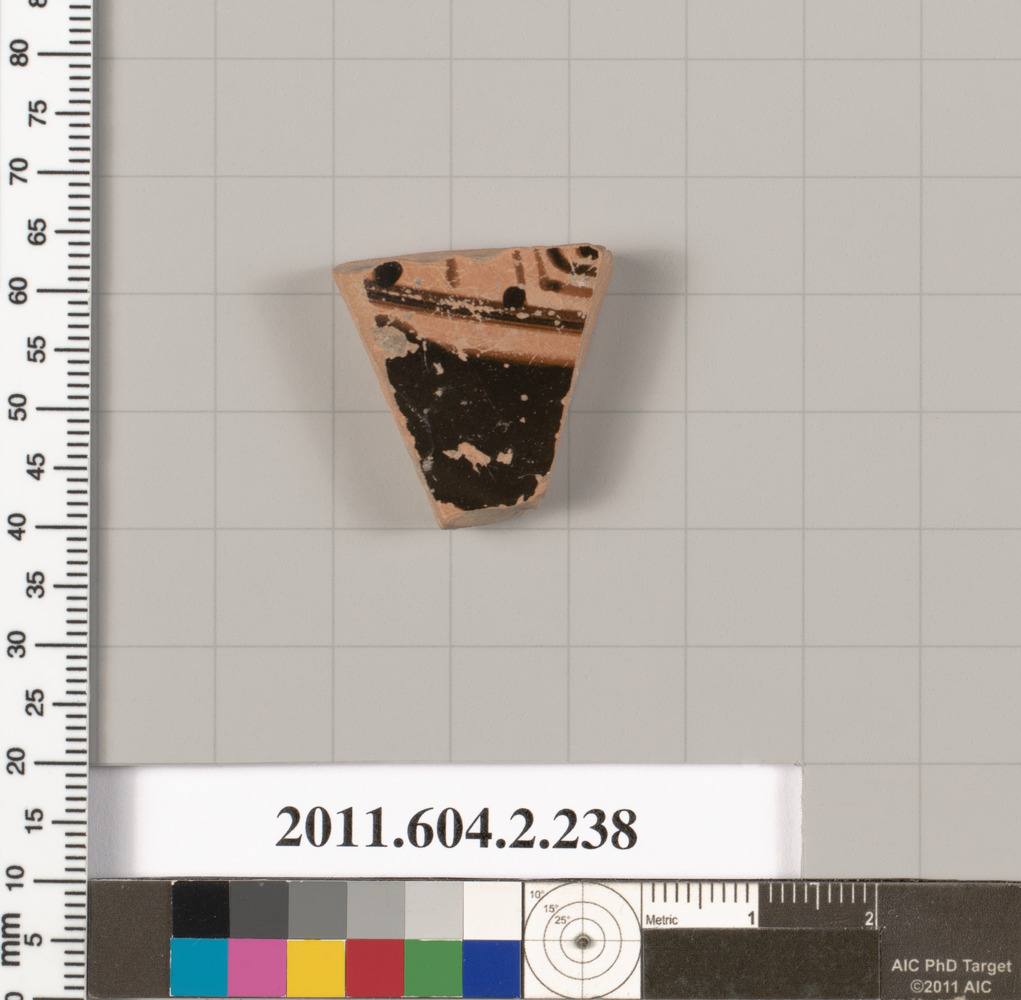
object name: stamnos fragment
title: Terracotta fragment of a stamnos (jar)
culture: greek, attic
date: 460-440 BCE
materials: terracotta